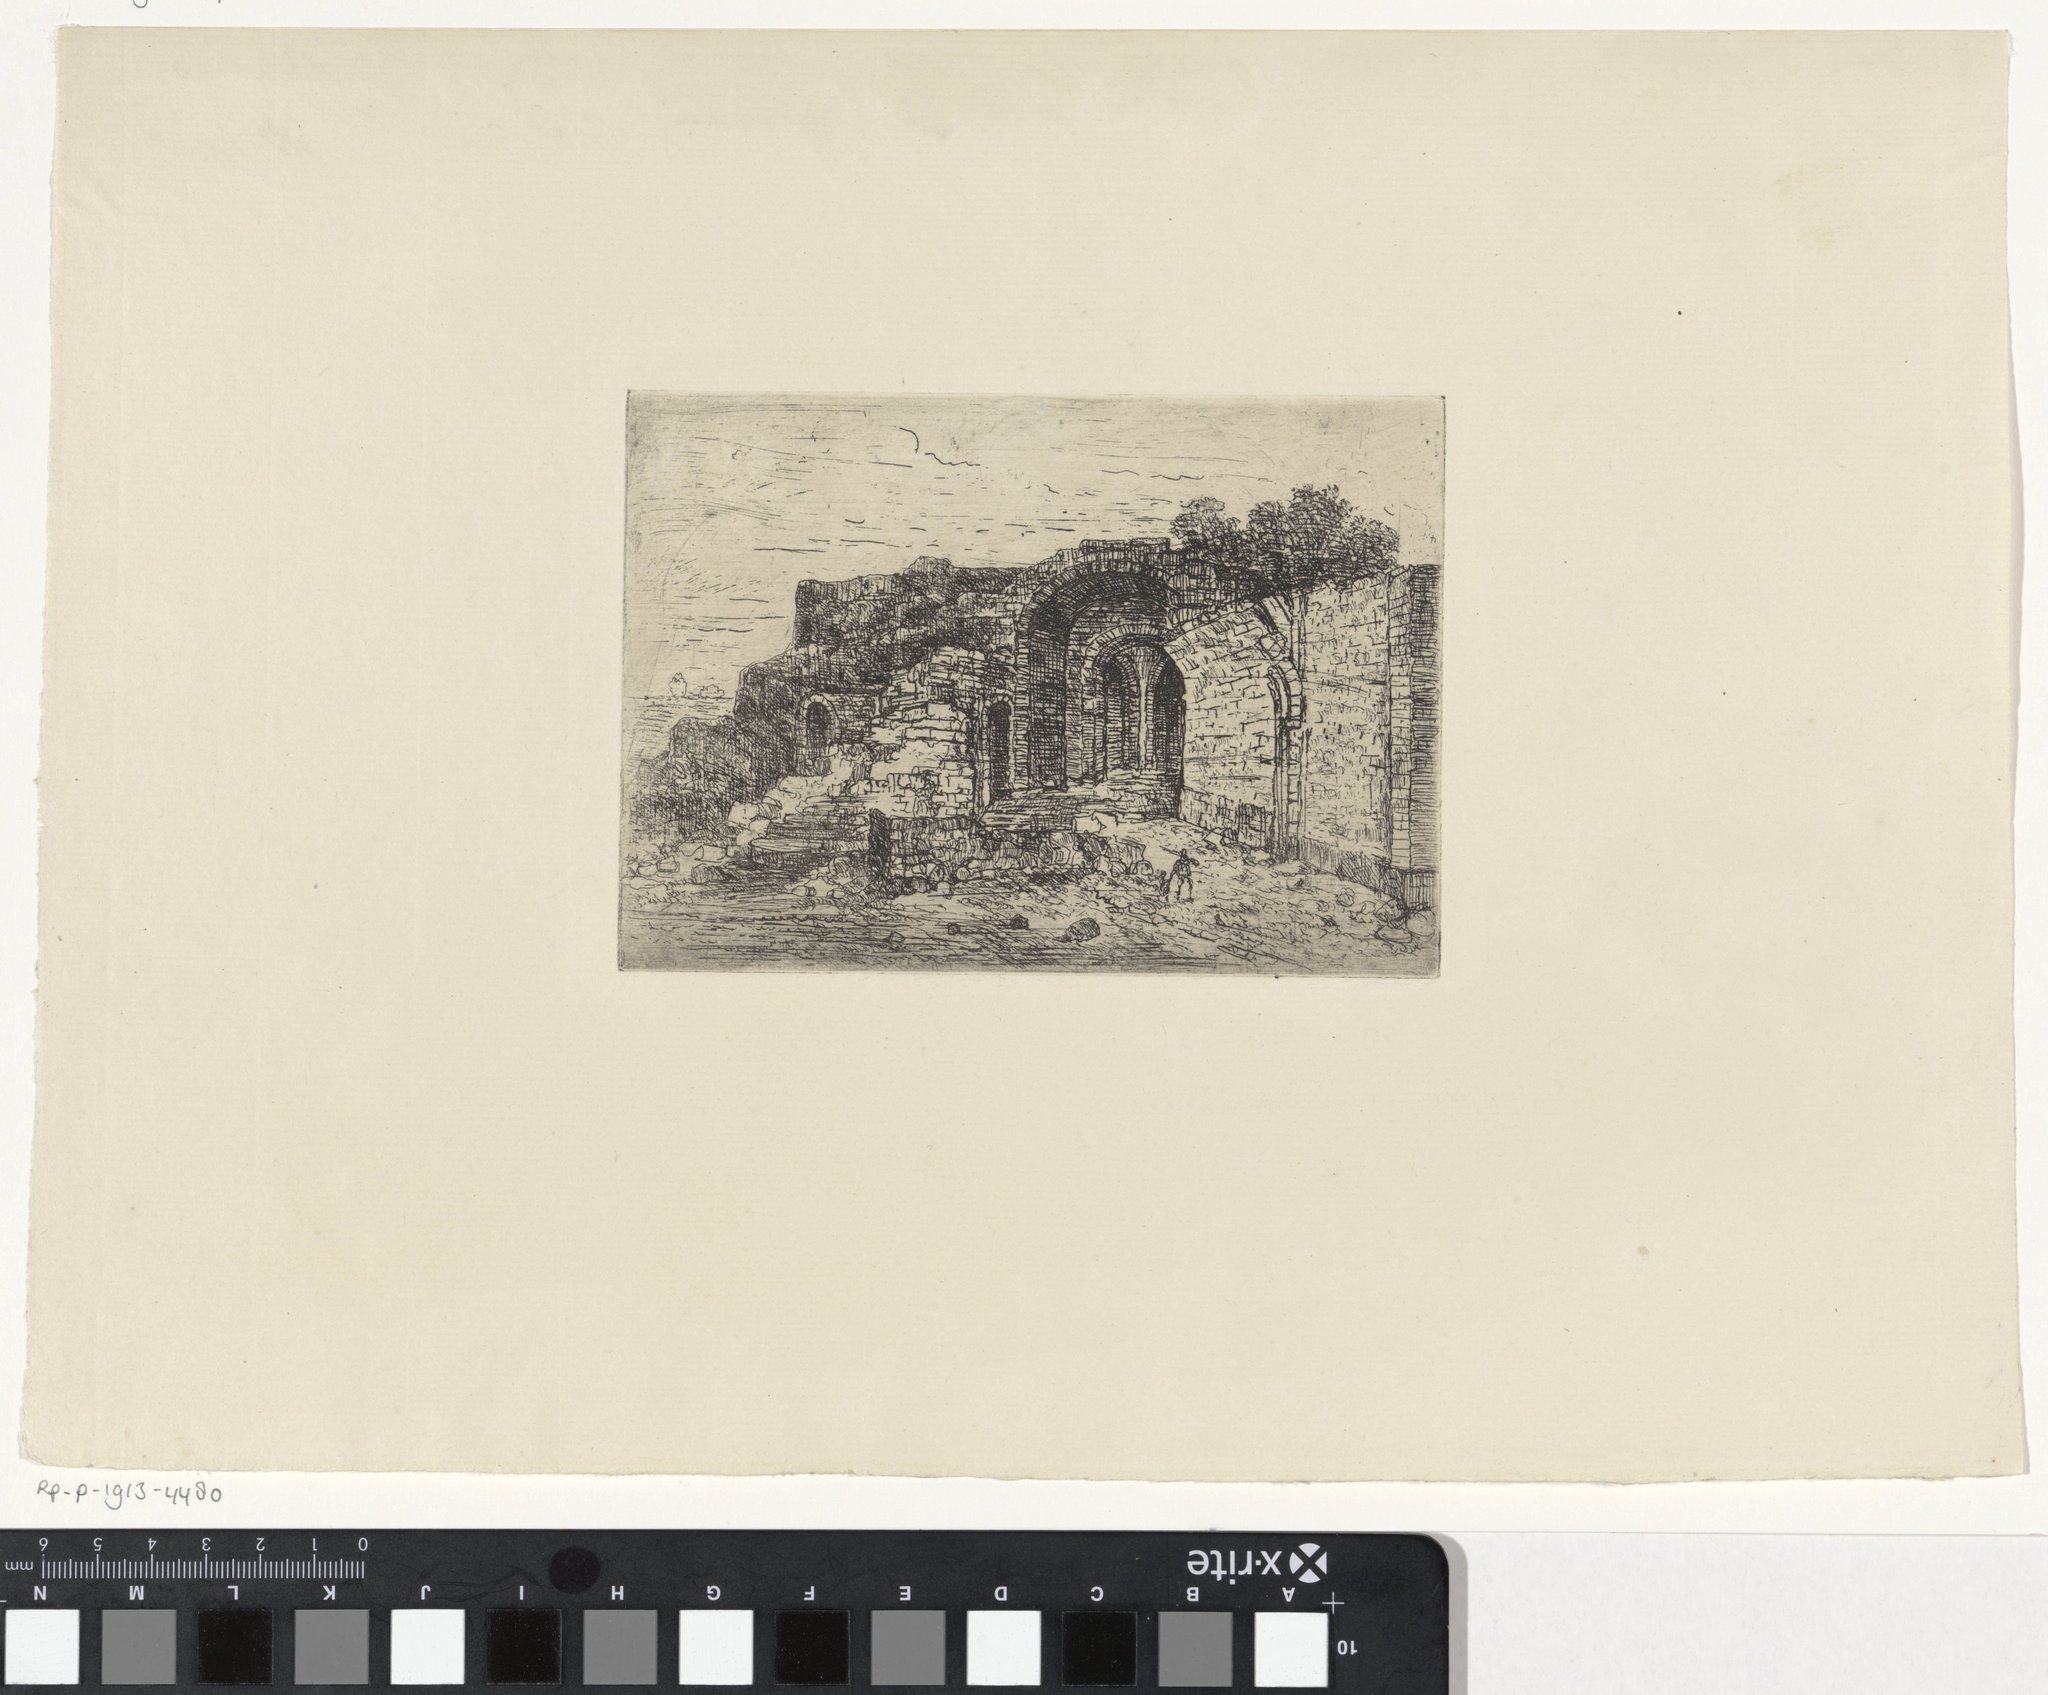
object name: print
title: Ruïnes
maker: alexander schaepkens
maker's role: draughtsman, print maker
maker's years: 1815-1899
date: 1830-1899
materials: paper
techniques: etching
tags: ruin of a building ~ architecture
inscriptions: collector's mark: Lugt 2228